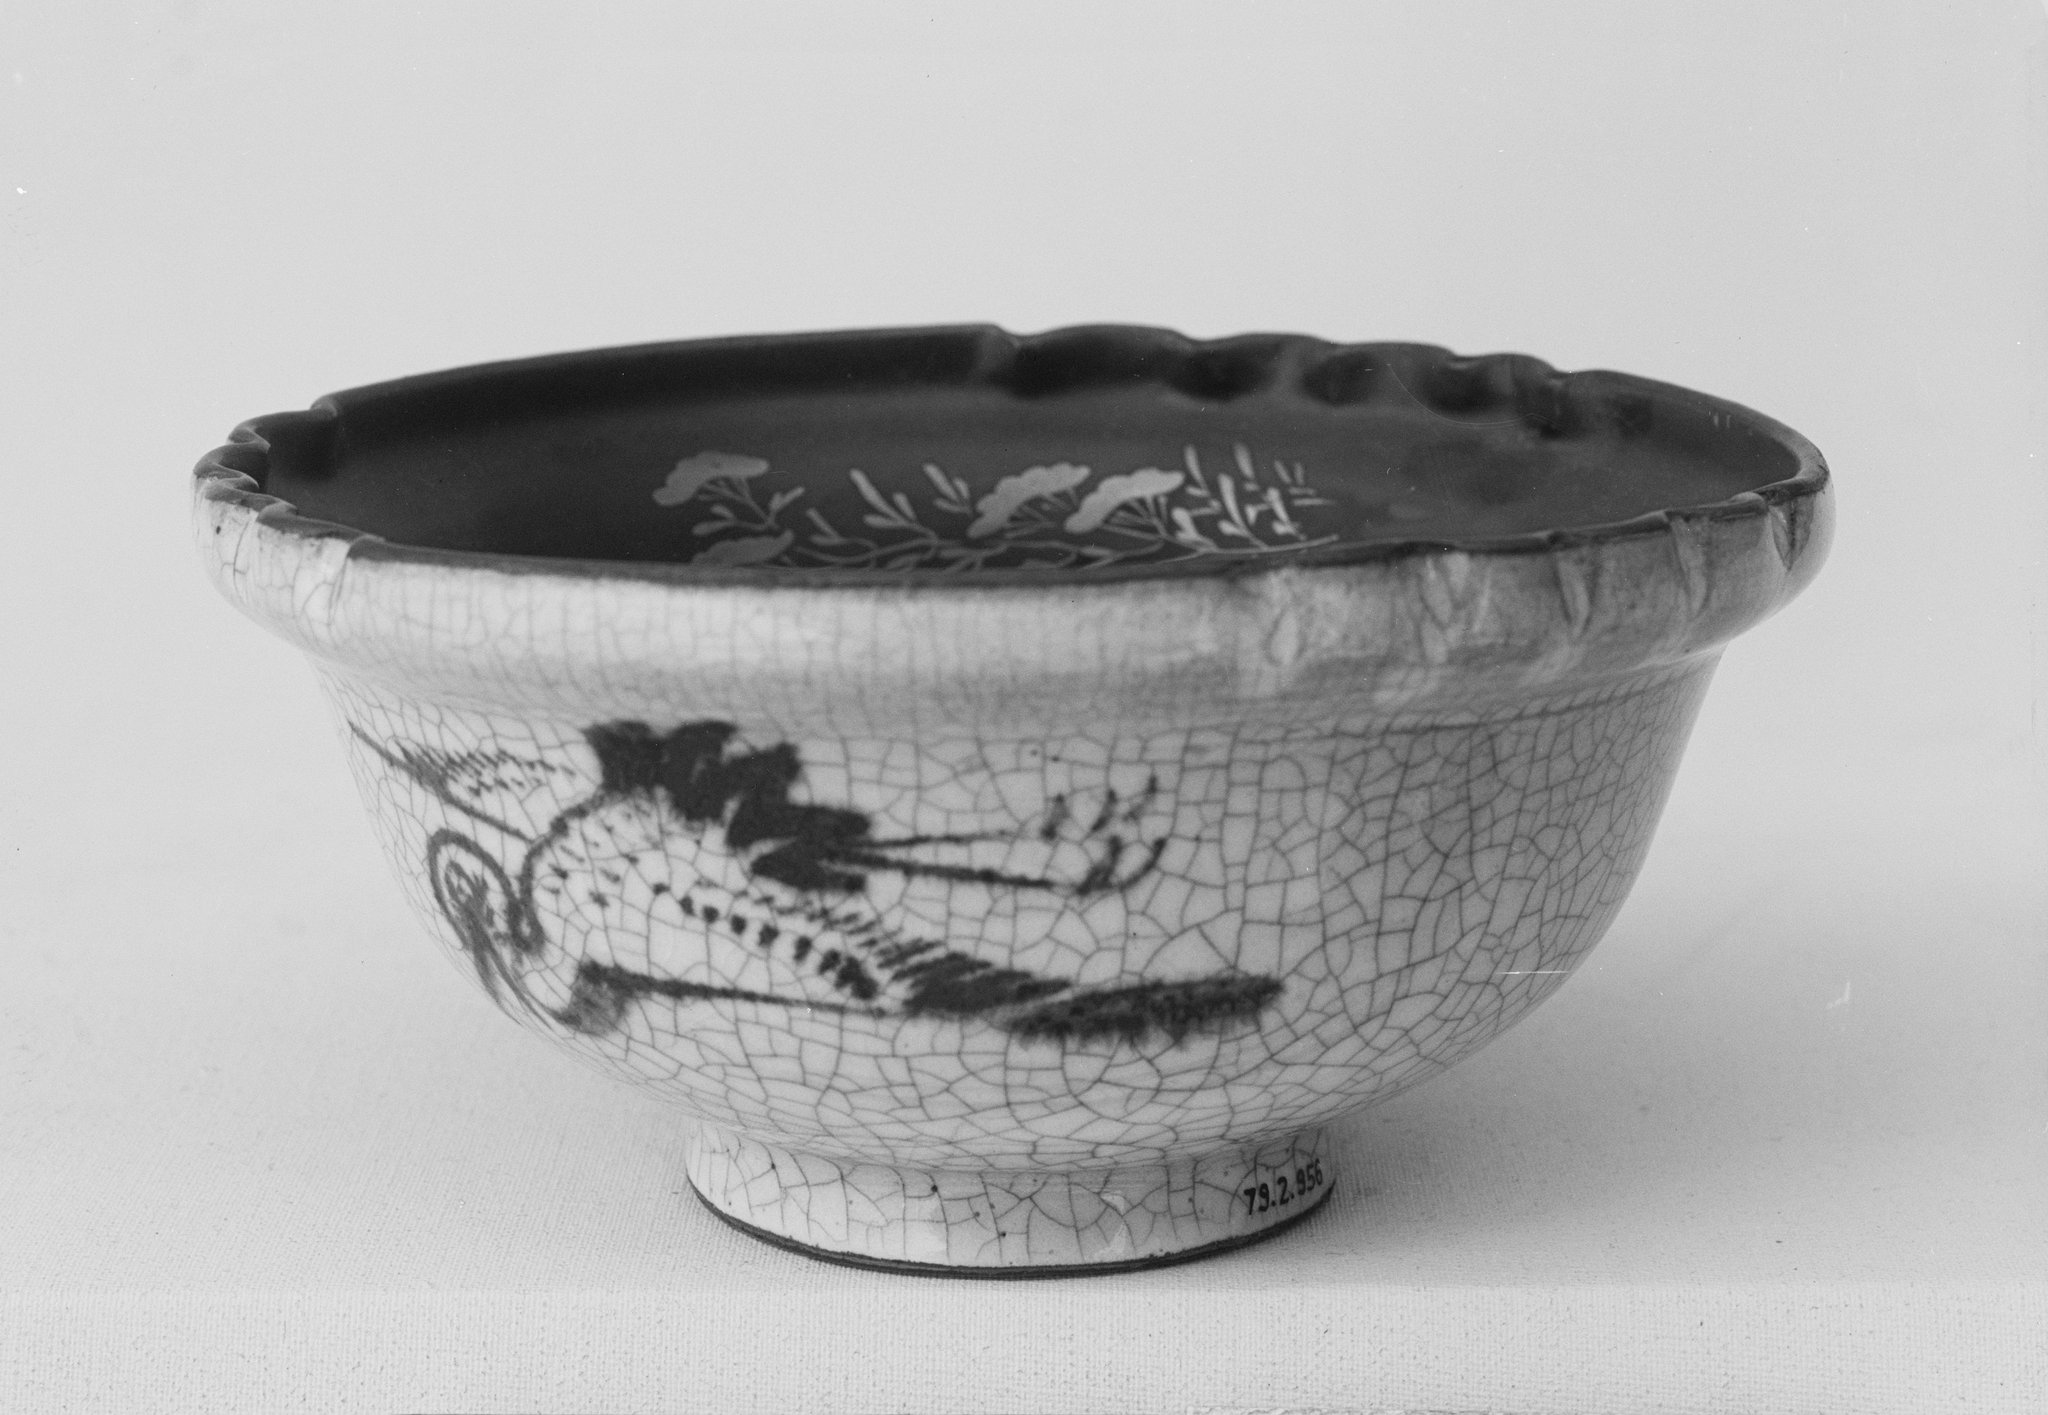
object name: bowl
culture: japanese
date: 1701-1800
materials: clay, glaze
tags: cranes